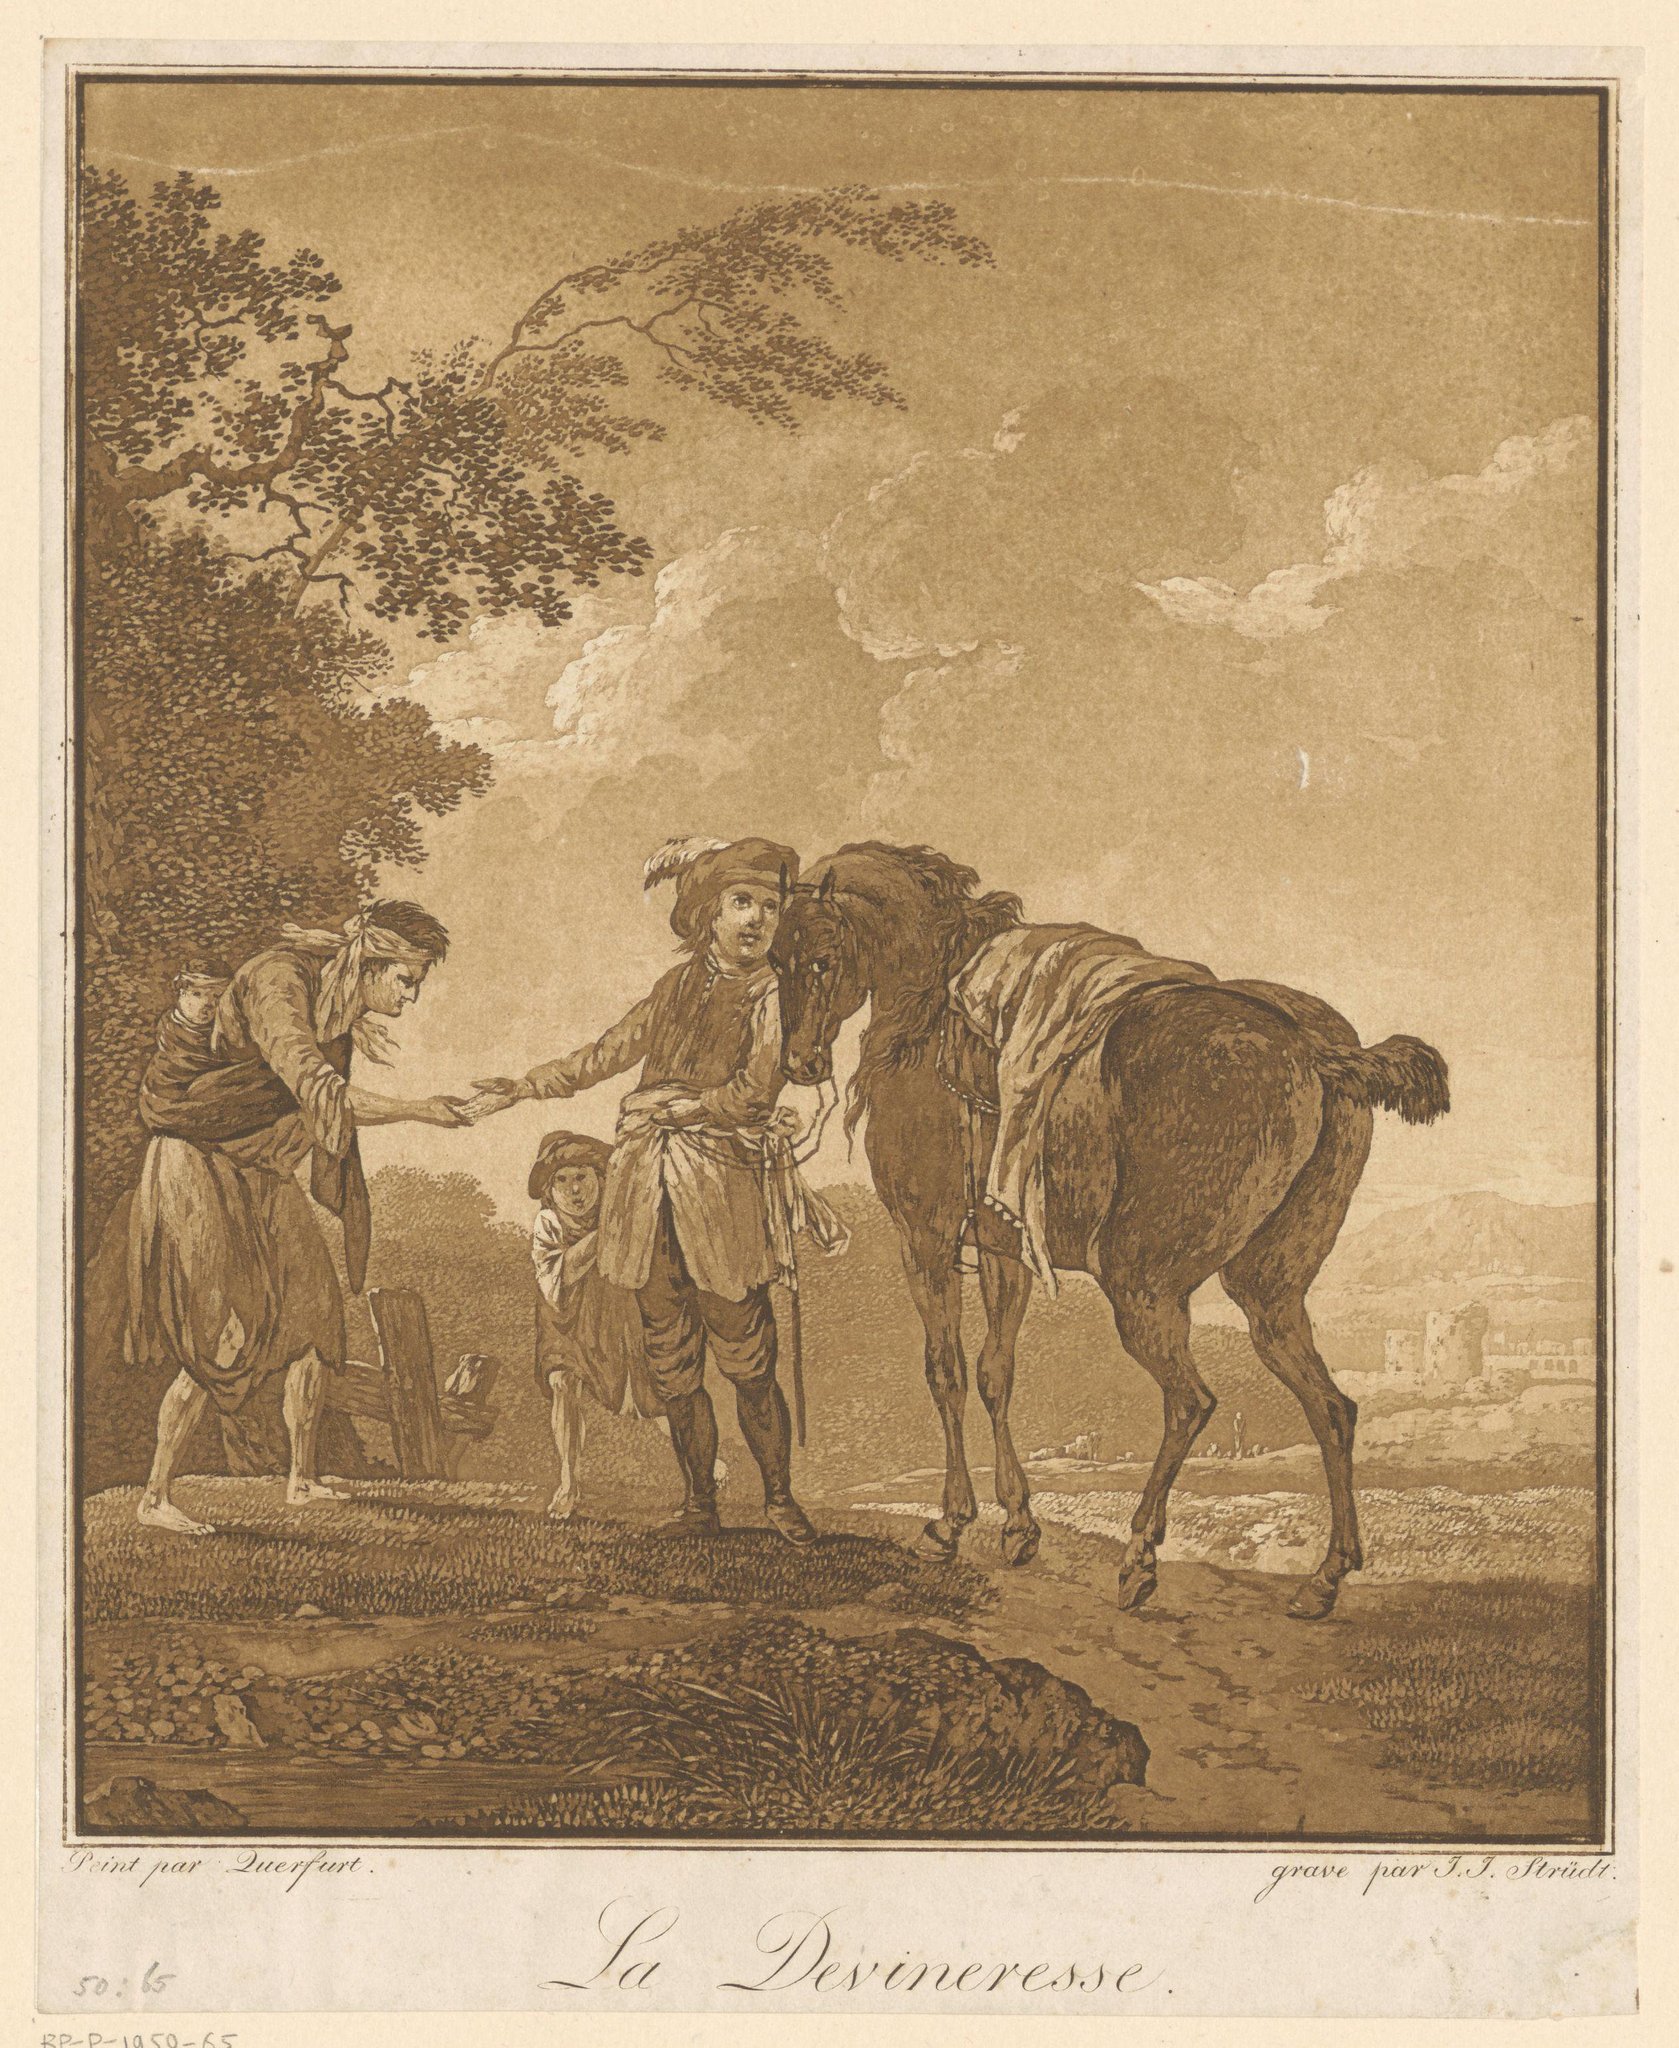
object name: print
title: La Devineresse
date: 1783-1807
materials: paper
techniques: aquatint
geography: germany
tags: horse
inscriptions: collector's mark: Lugt 2228